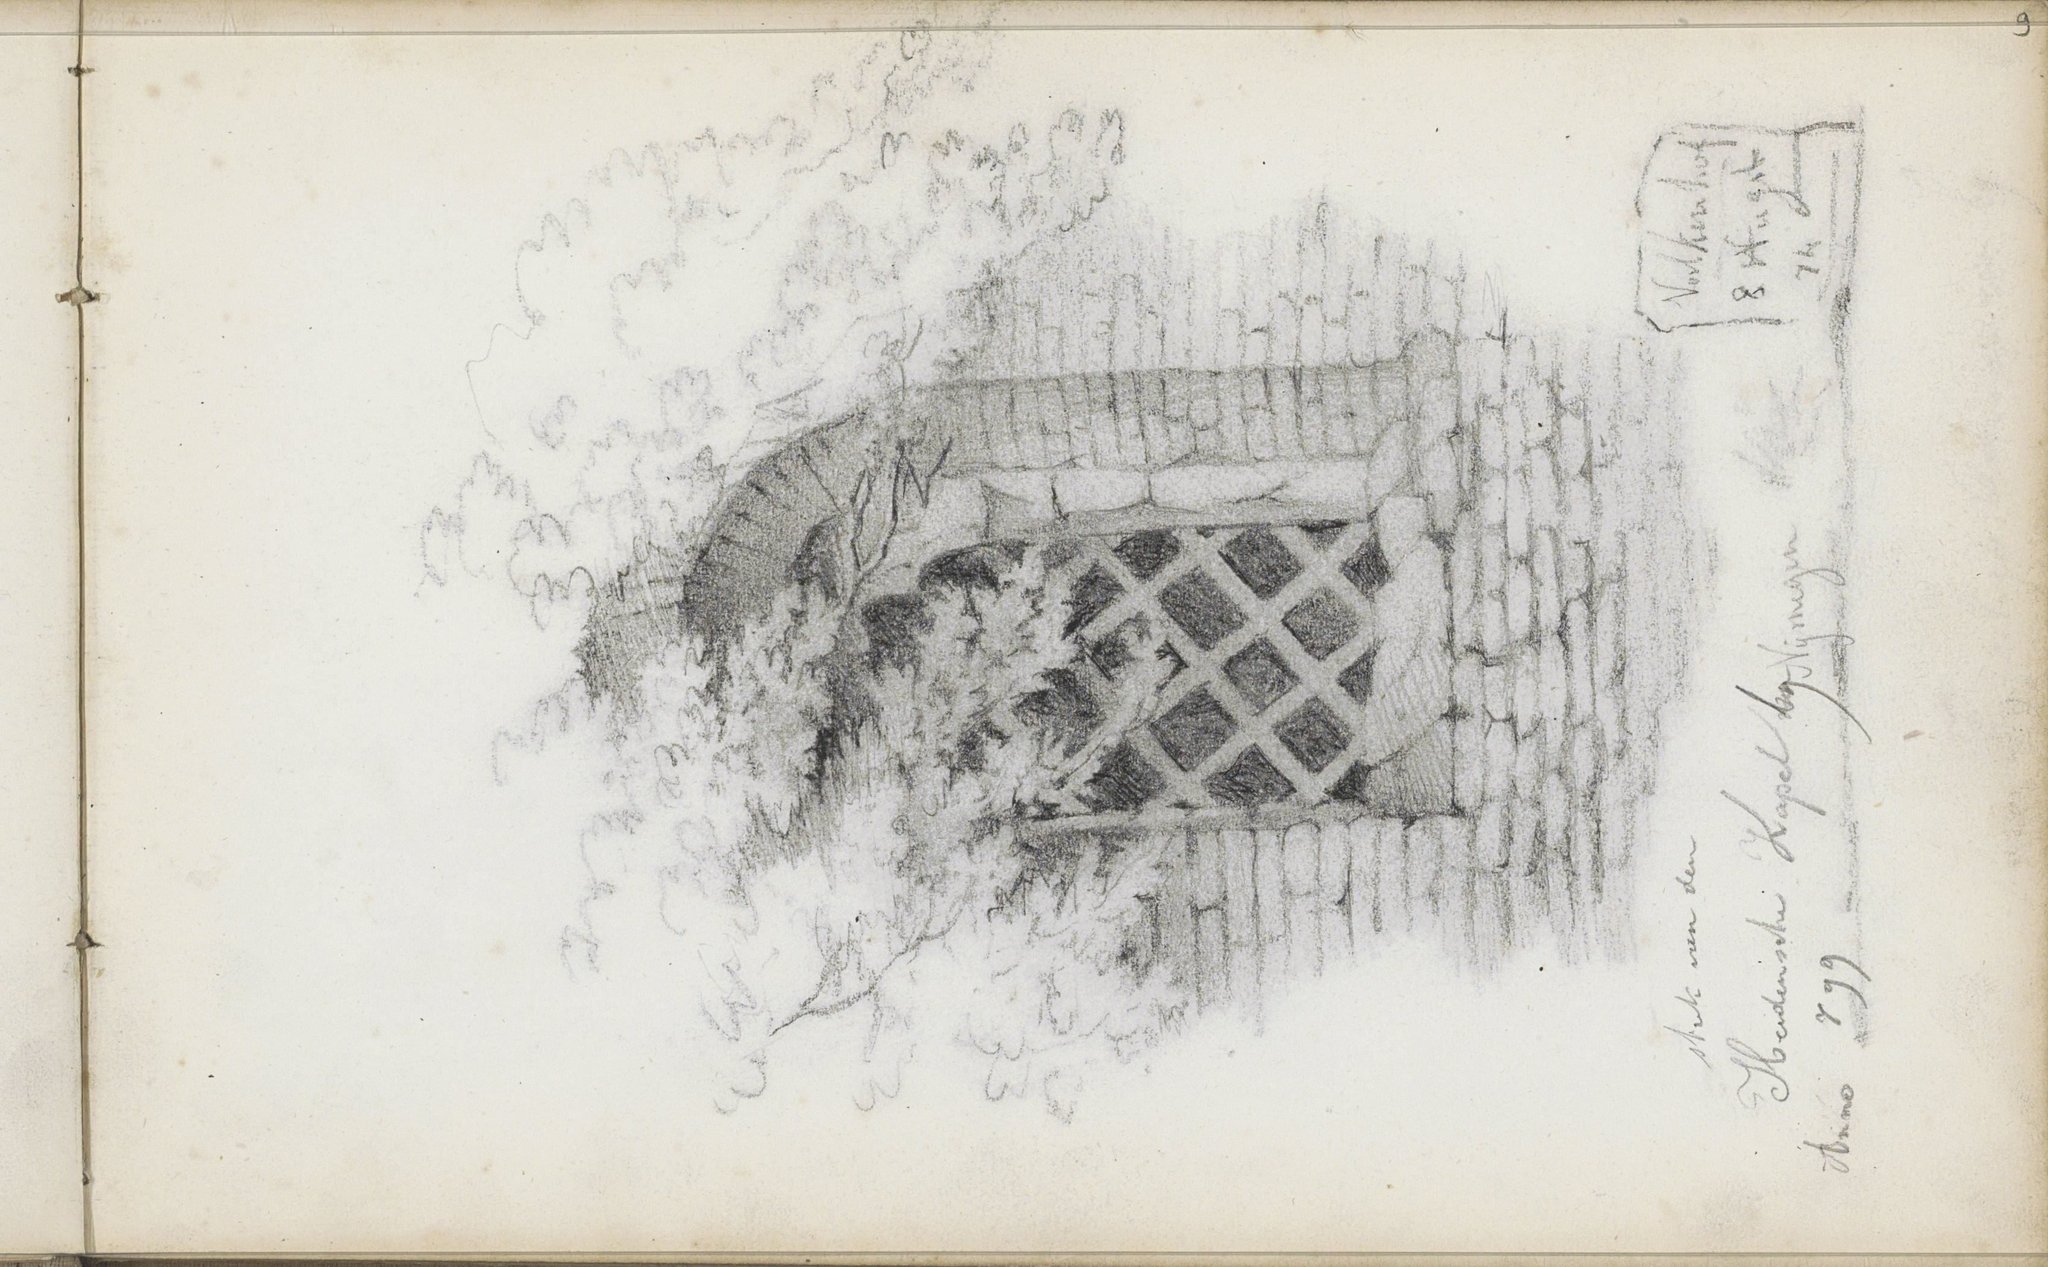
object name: sketchbook leaf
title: Venster van de Heidense Kapel op 't Valkhof te Nijmegen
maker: willem cornelis rip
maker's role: draughtsman, painter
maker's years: 1856-1922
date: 1808-1874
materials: paper, pencil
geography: nijmegen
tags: window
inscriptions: date and inscription: ‘stuk van den/ Heidensche Kapel bij Nijmegen. Anno 799/ Valkenhof/ 8 Augst/ 74’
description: Blad 9 recto uit een schetsboek met 47 bladen.